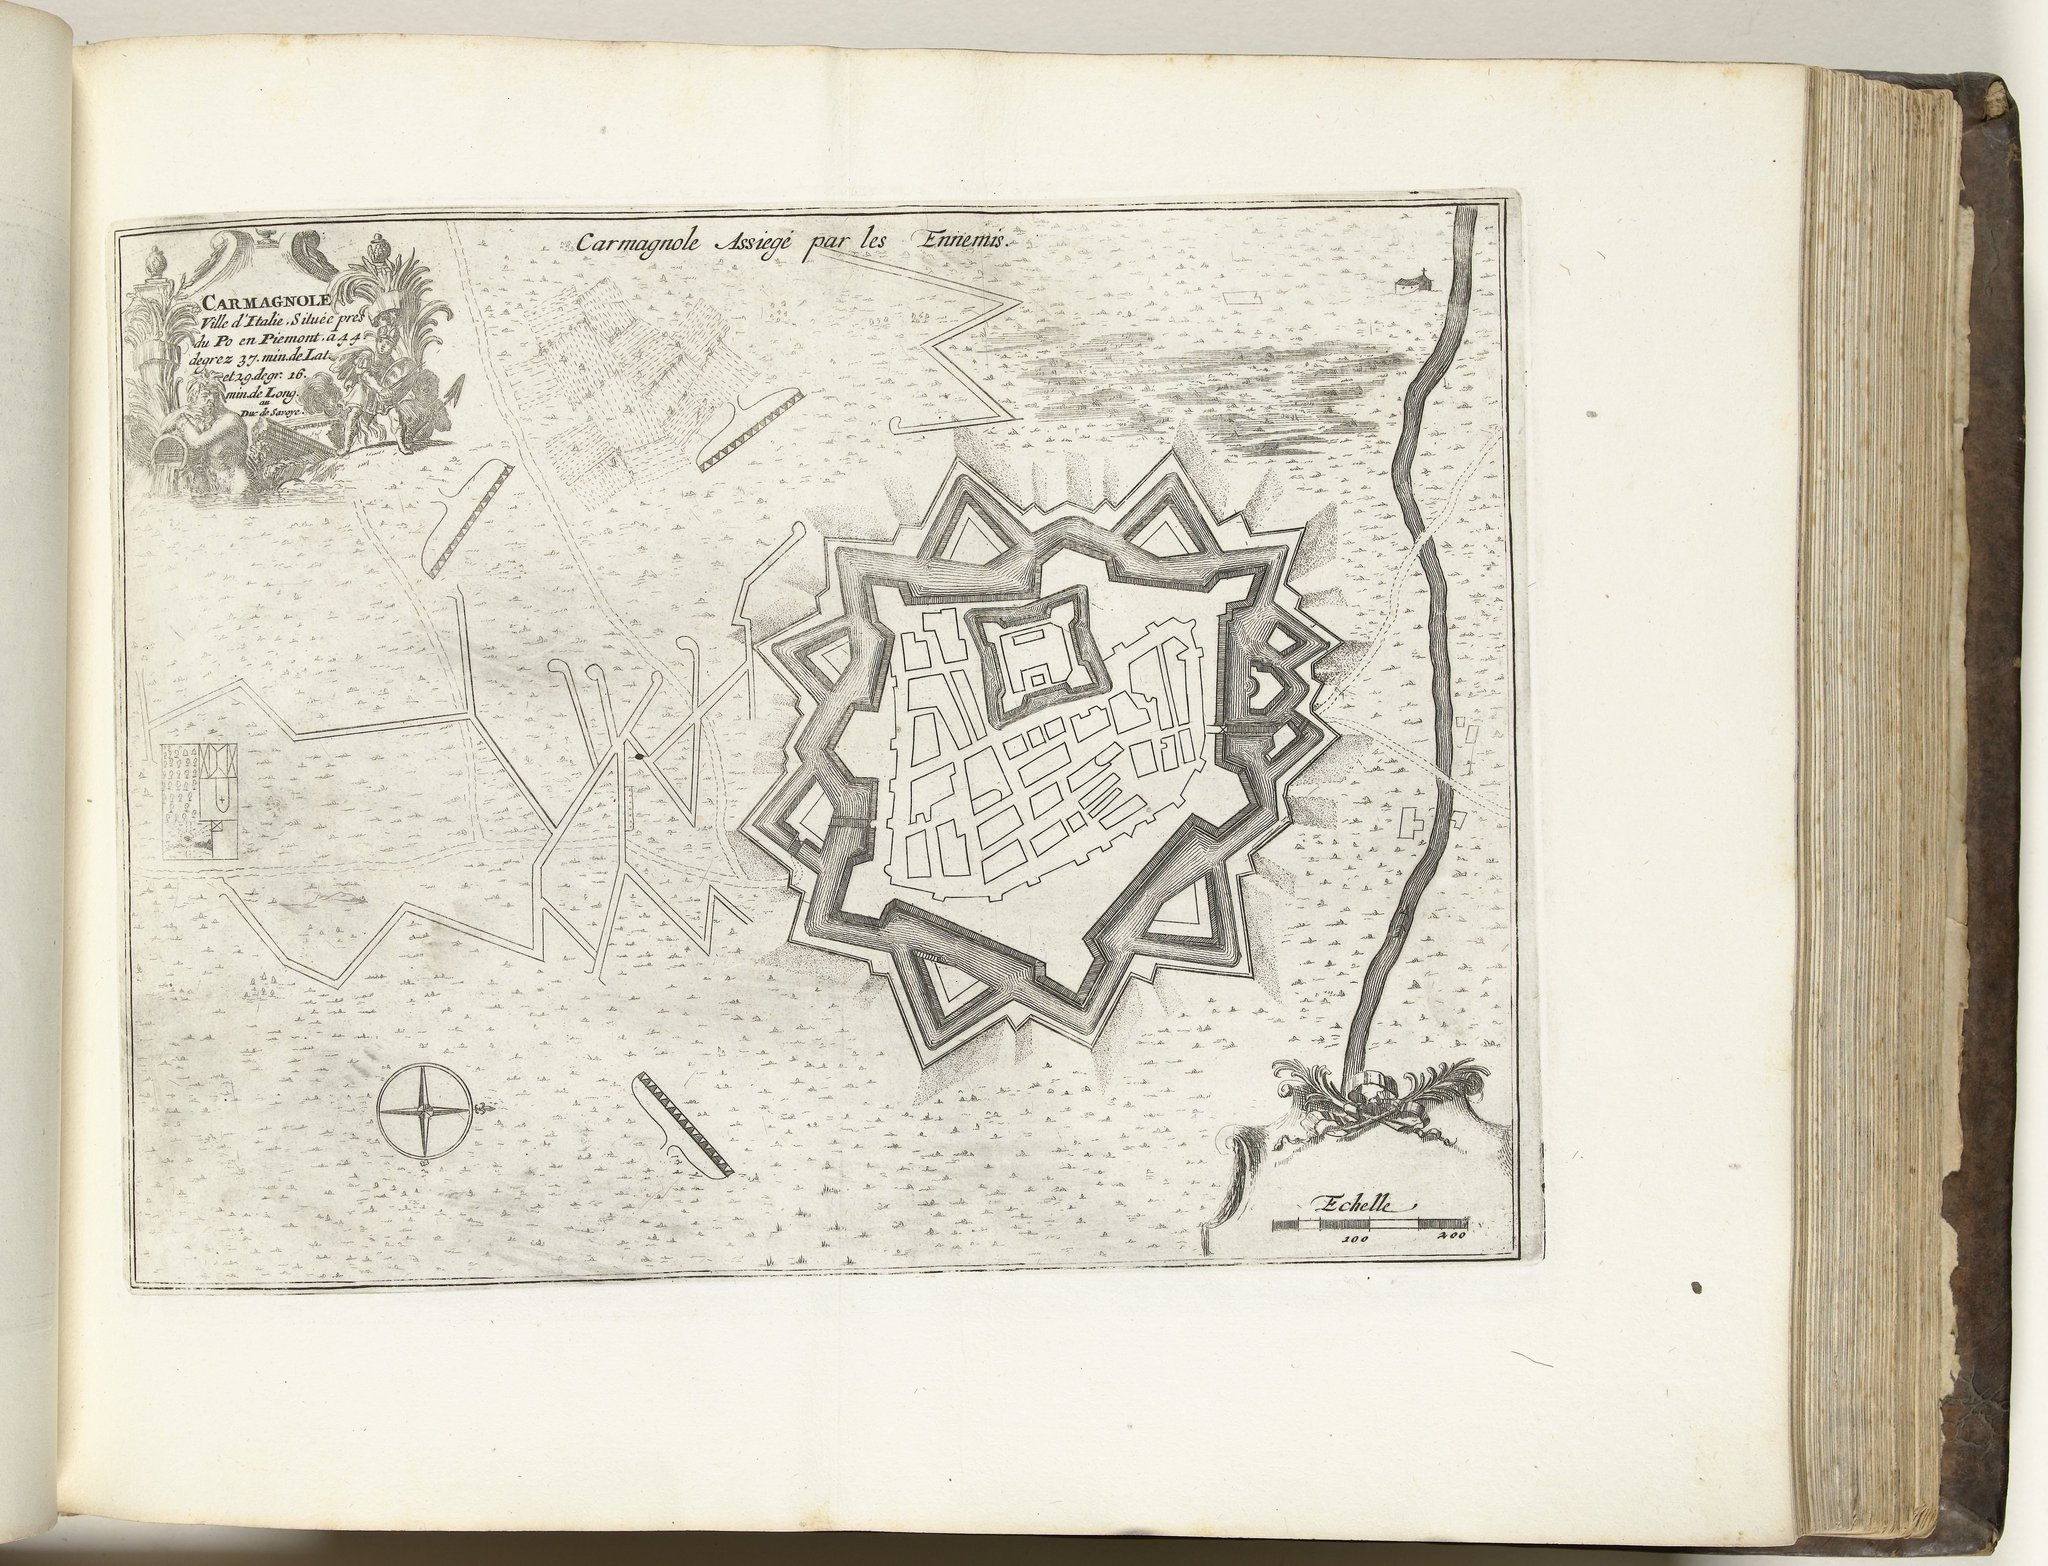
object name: print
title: Carmagnole Ville d'Italie, Située pres du Po en Piemond (...) / Campagnole Assiegé par les Ennemis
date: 1695-1697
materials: paper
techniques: etching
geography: france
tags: fortress, maps of cities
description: Plattegrond met de loopgraven van de belegeraars en de versterkingen om de Italiaanse stad Carmagnola tijdens de belegering. Onderdeel van het vierde deel (1697) van het prentwerk waarin gebundeld zijn de acht delen van Les forces de l'Europe uitgegeven tussen 1693-1697. Het prentwerk bestaat uit 175 platen met plannen (afkomstig van Sébastien Le Prestre, Seigneur de Vauban) van vermaarde sterke steden en vestingen in de Negenjarige Oorlog. Titel en opschriften in het Frans.